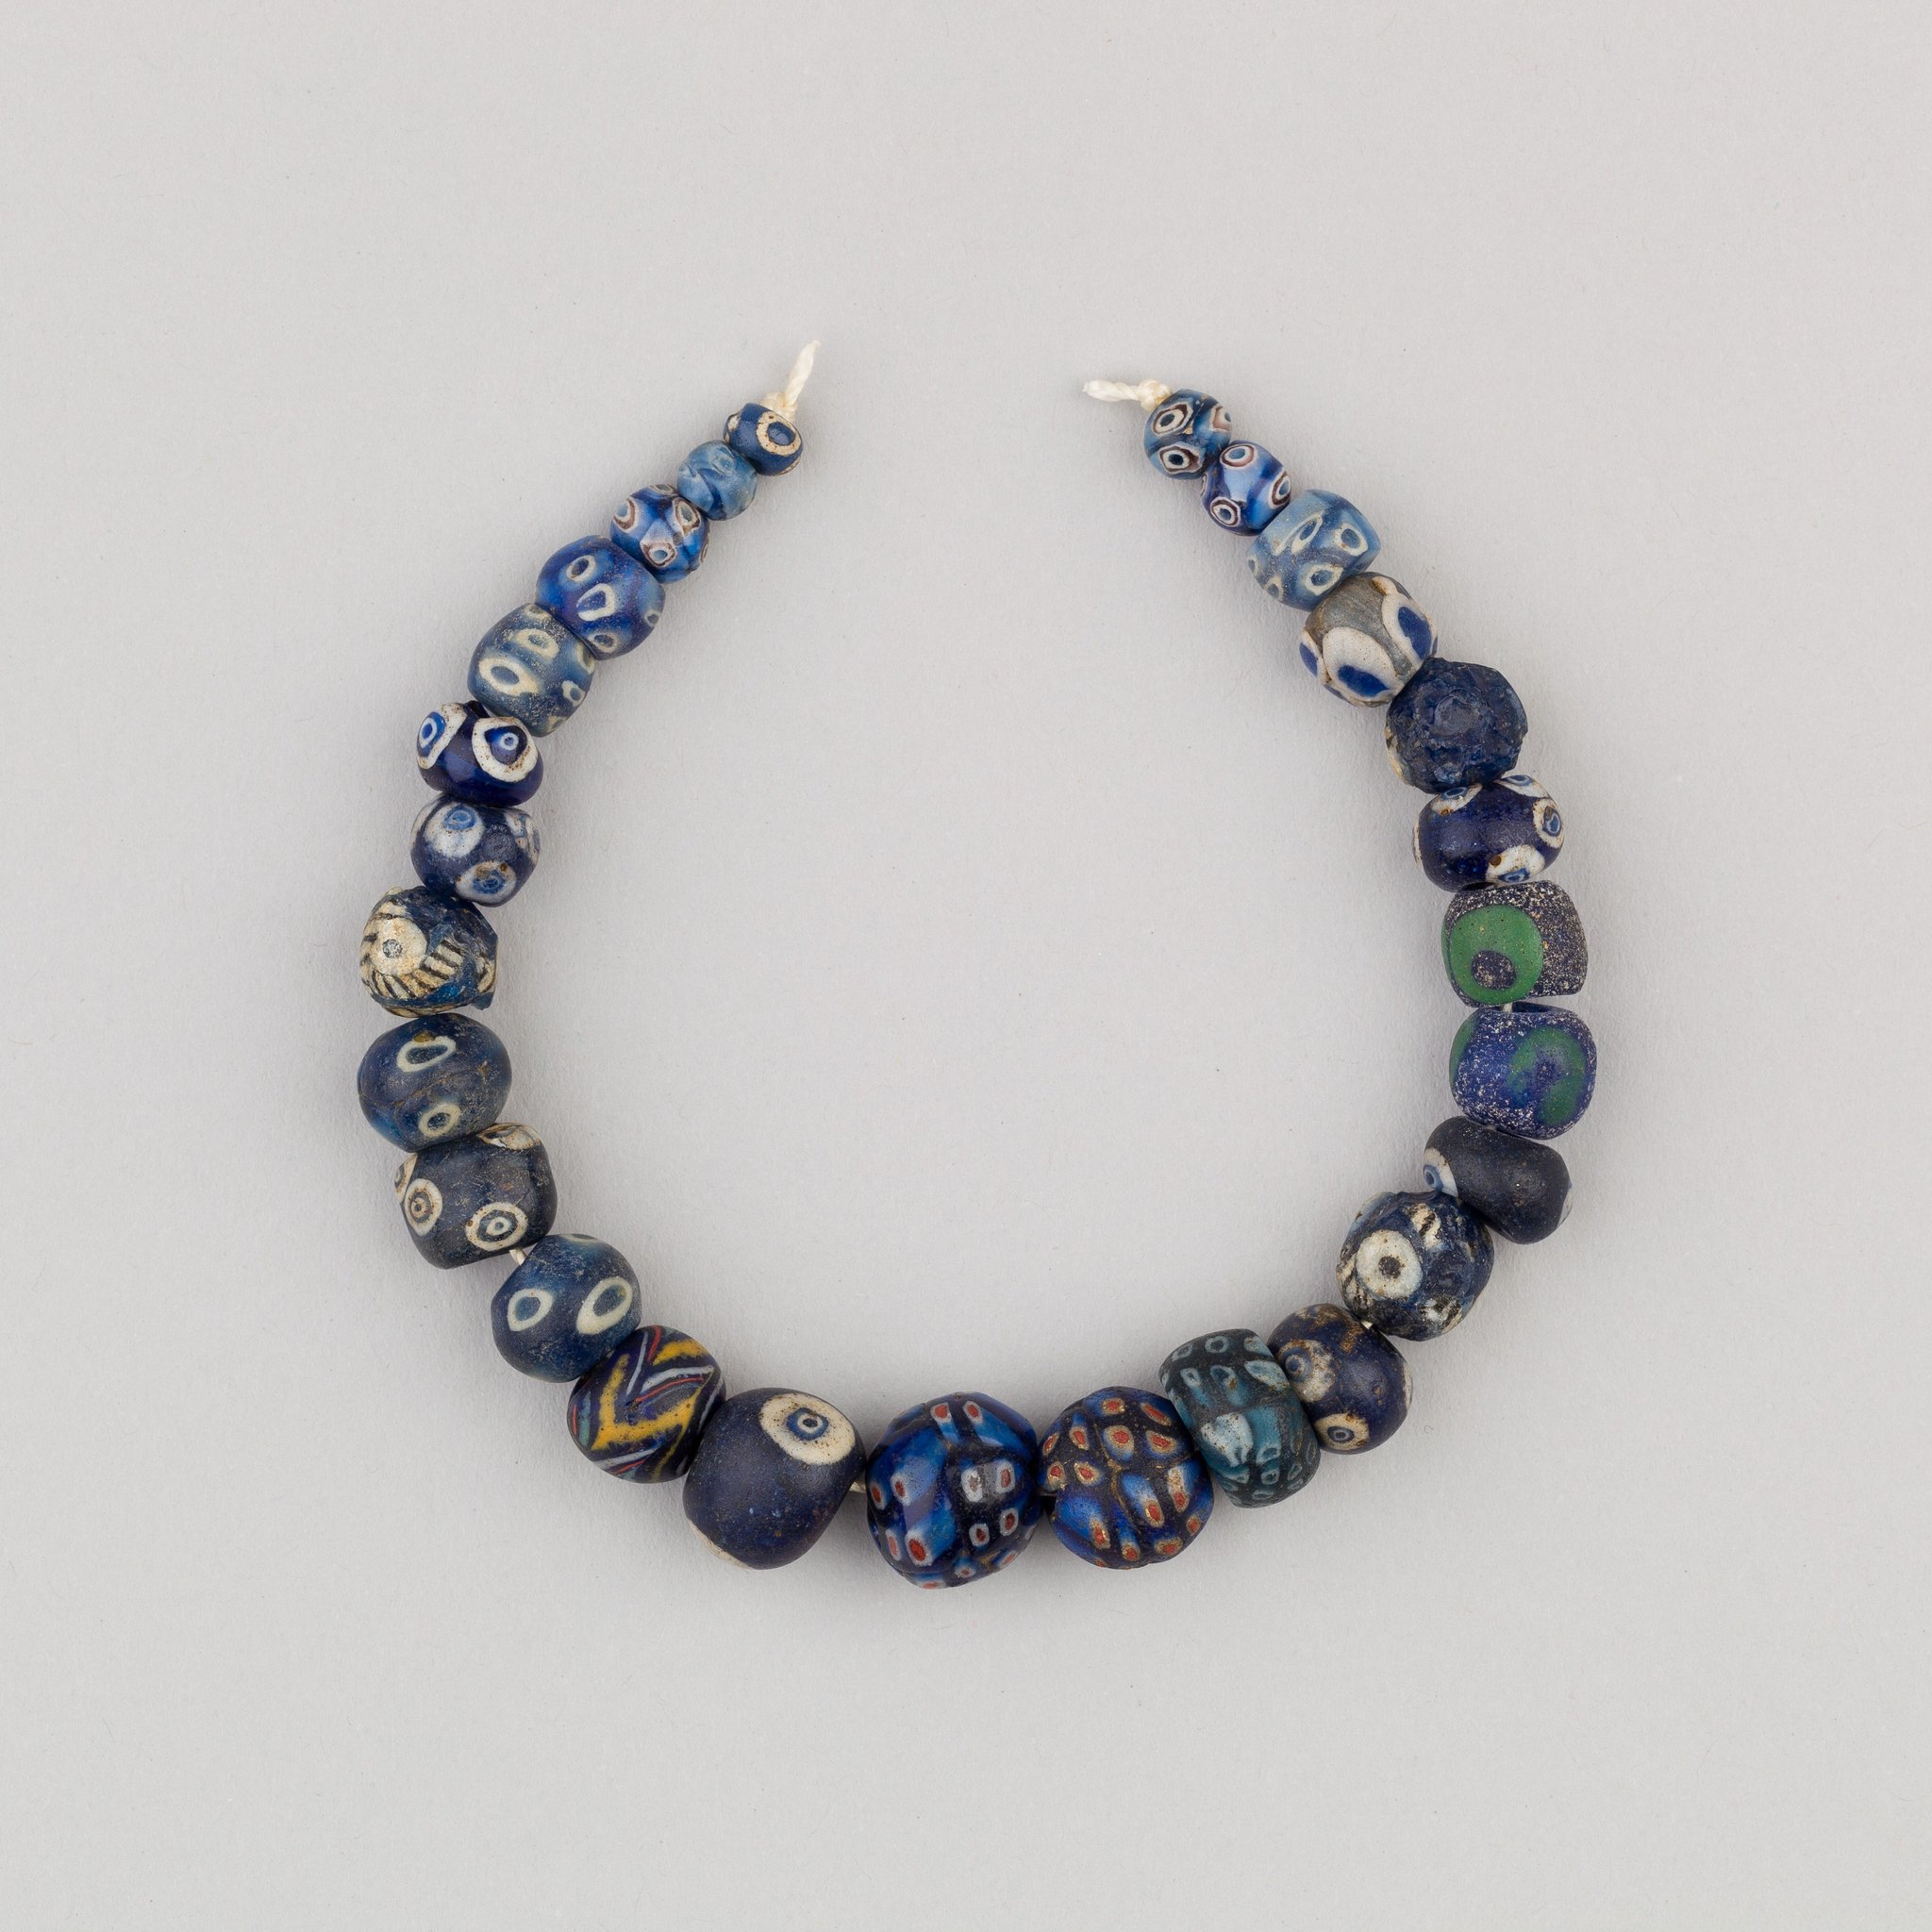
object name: necklace, bead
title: String of 27 Eyed Beads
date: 1-366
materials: glass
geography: egypt